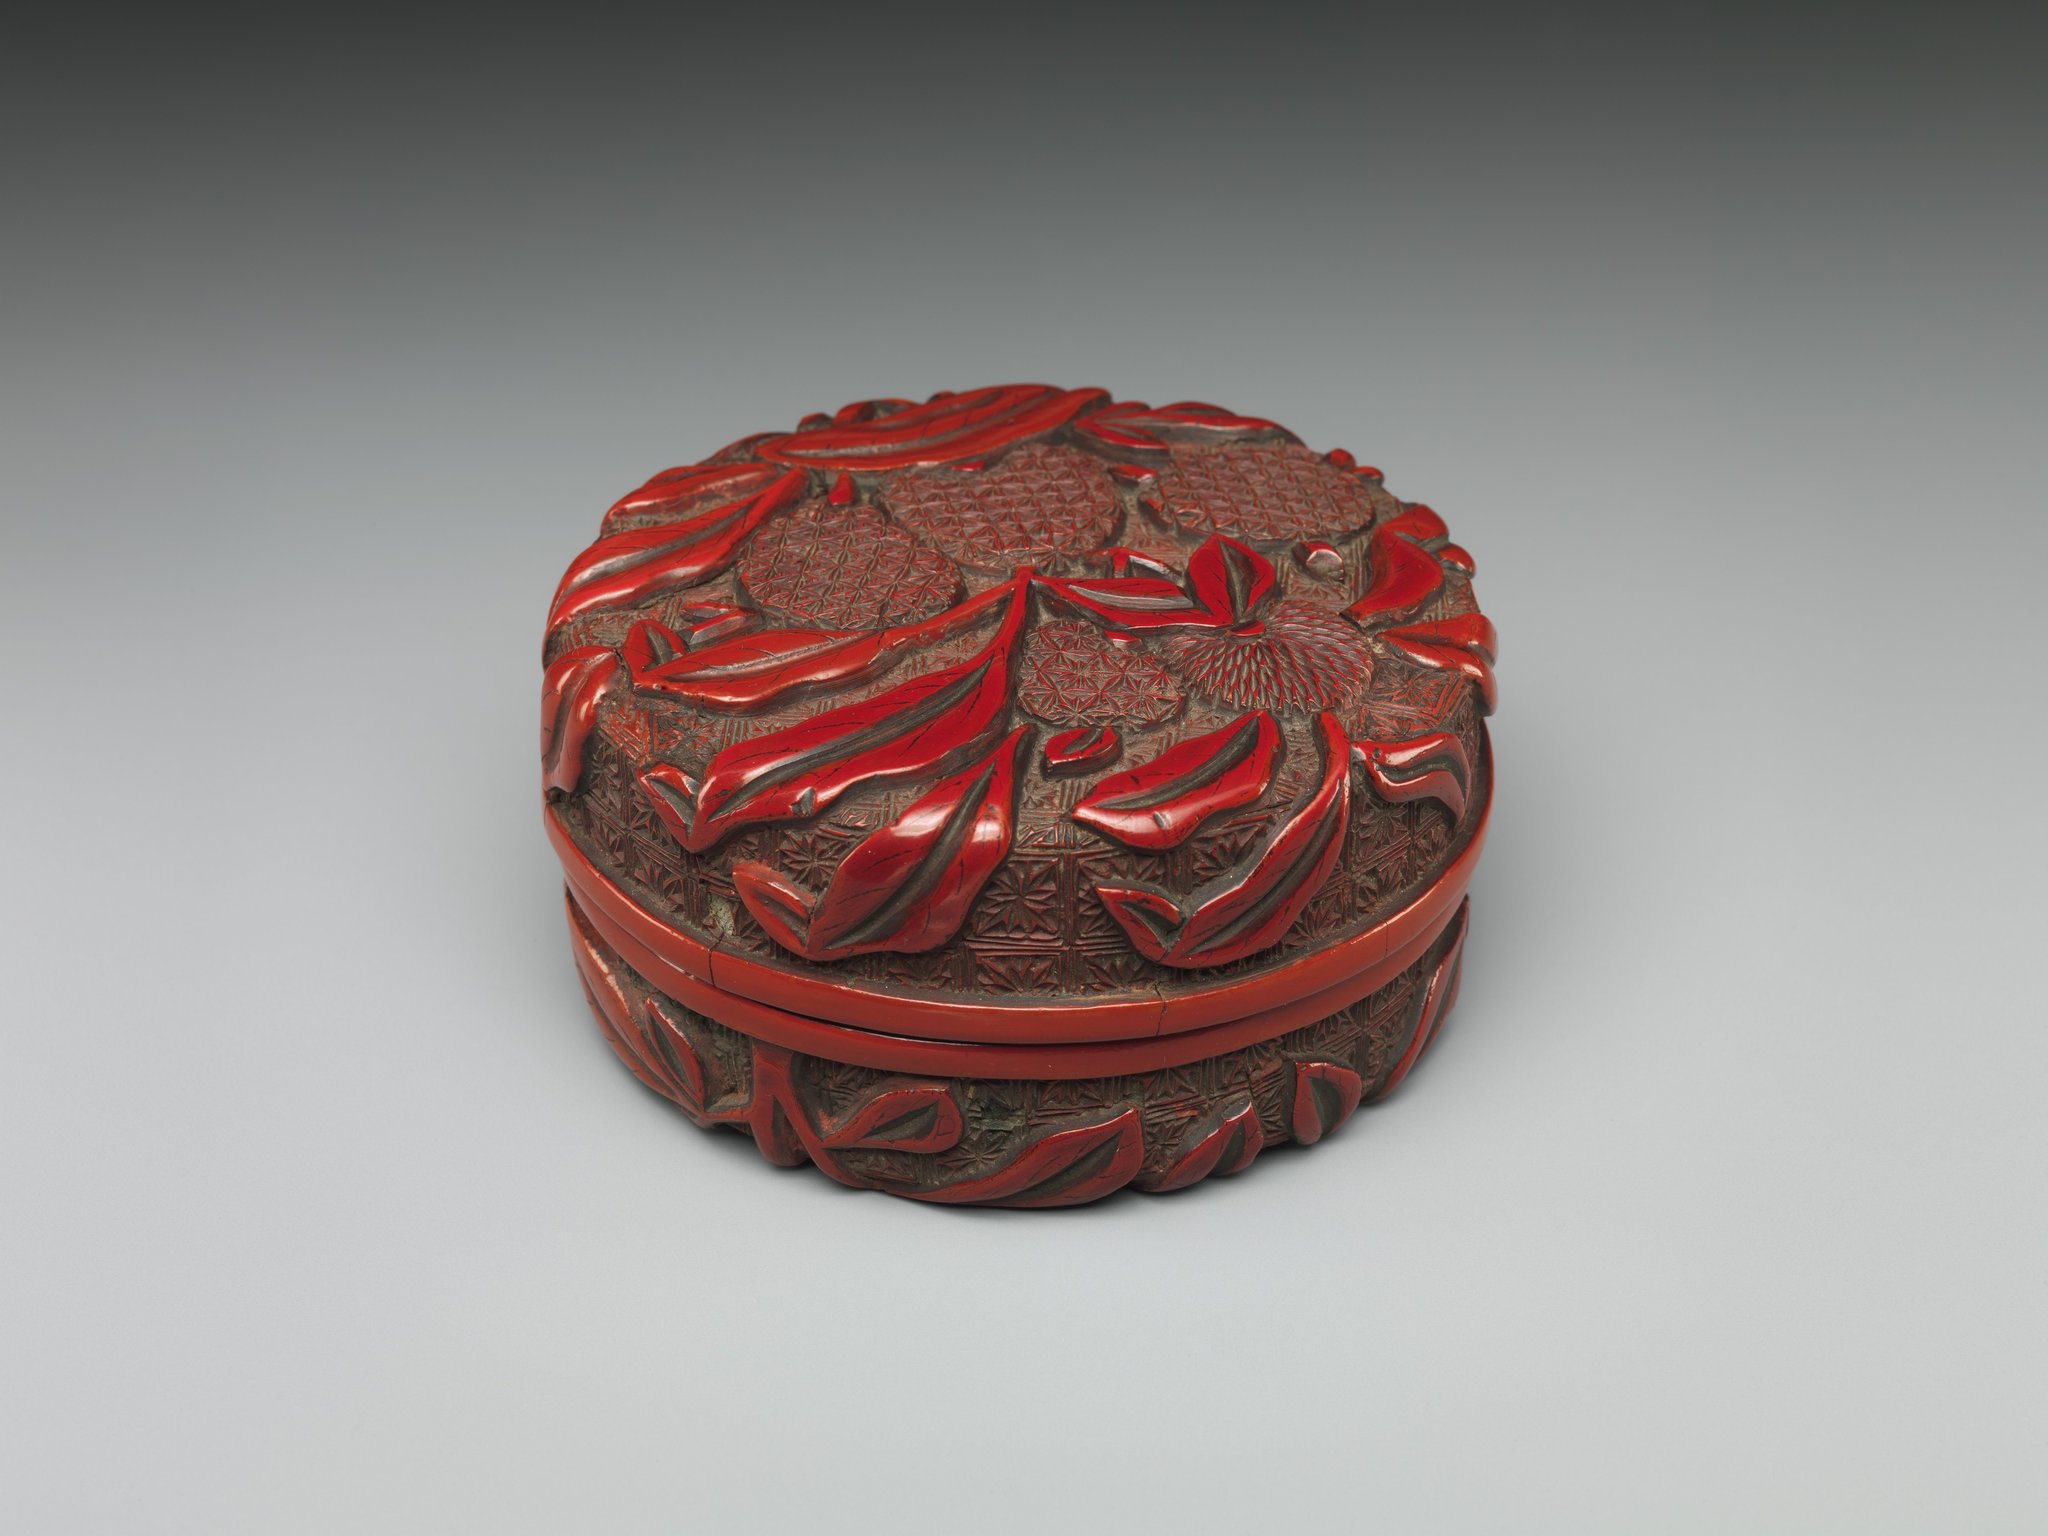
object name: box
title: Box with lychees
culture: chinese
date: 1501-1600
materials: lacquer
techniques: carving